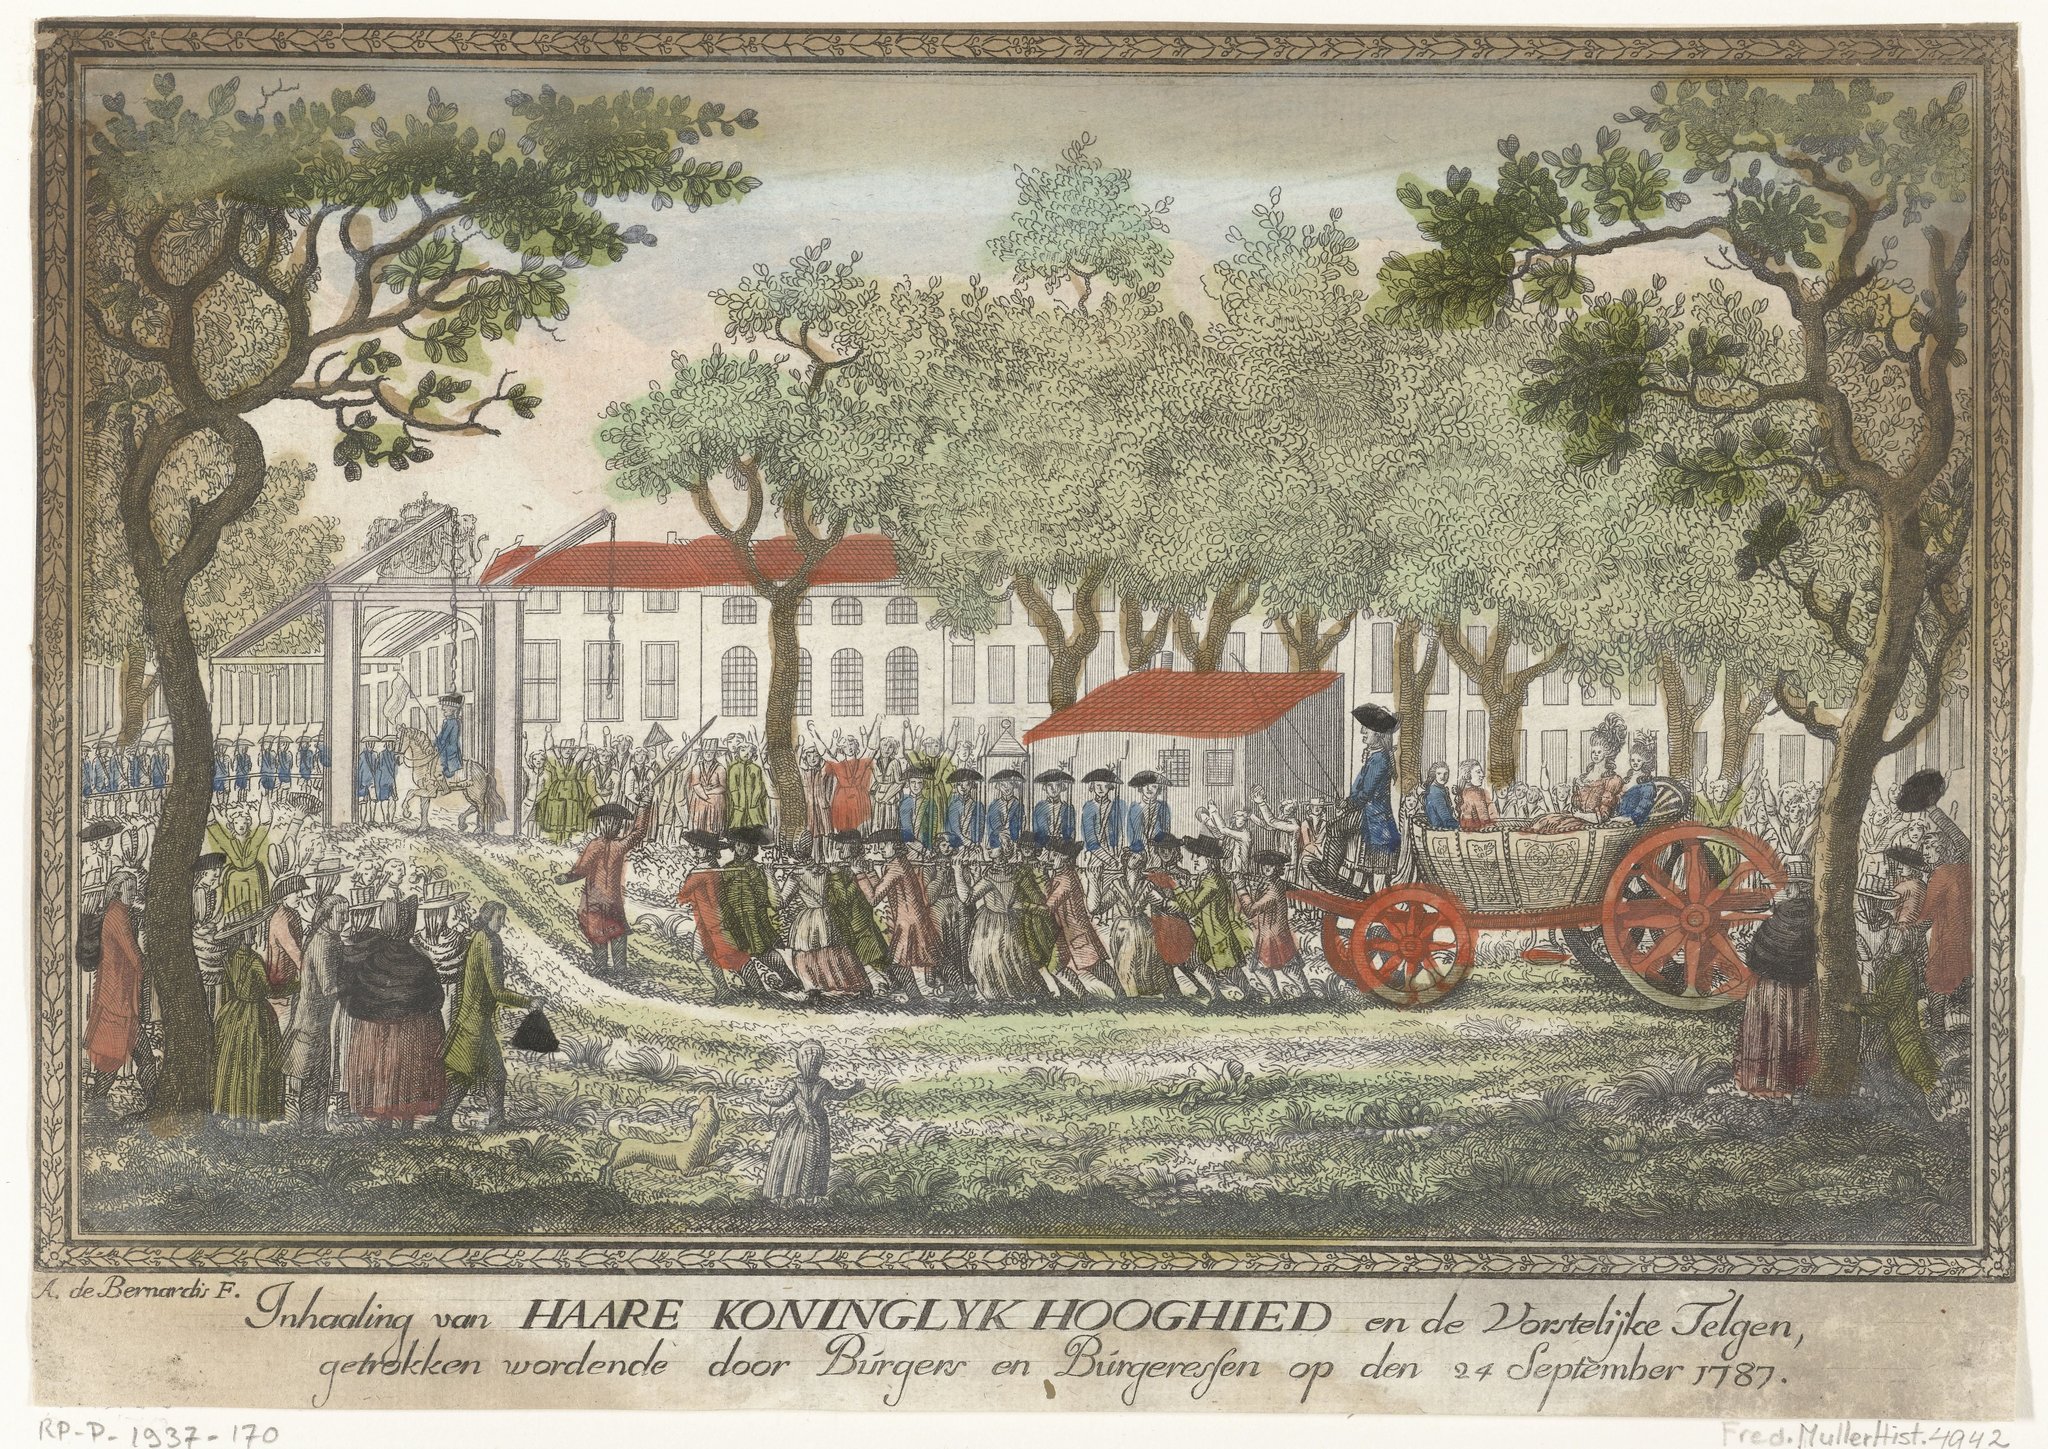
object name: print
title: Intocht van Wilhelmina van Pruisen en haar kinderen in Den Haag, 1787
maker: andrea de bernardis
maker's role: print maker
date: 1787-1789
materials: paper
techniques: etching, hand coloring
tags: william i of the netherlands, painter, wilhelmina of prussia (princess of orange), amsterdam, louise (prinses van oranje-nassau), willem george frederik (prins van oranje-nassau), four-wheeled, animal-drawn vehicle, e.g.: cab, carriage, coach, the hague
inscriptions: collector's mark: Lugt 2228, collector's mark: Lugt 2760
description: Wilhelmina van Pruisen en haar drie kinderen rijden de stad binnen in een koets die getrokken wordt door een groep burgers van Den Haag. De stoet wordt voorafgegaan door een groep militairen. Het volk staat langs de weg en verwelkomt de vorstin.